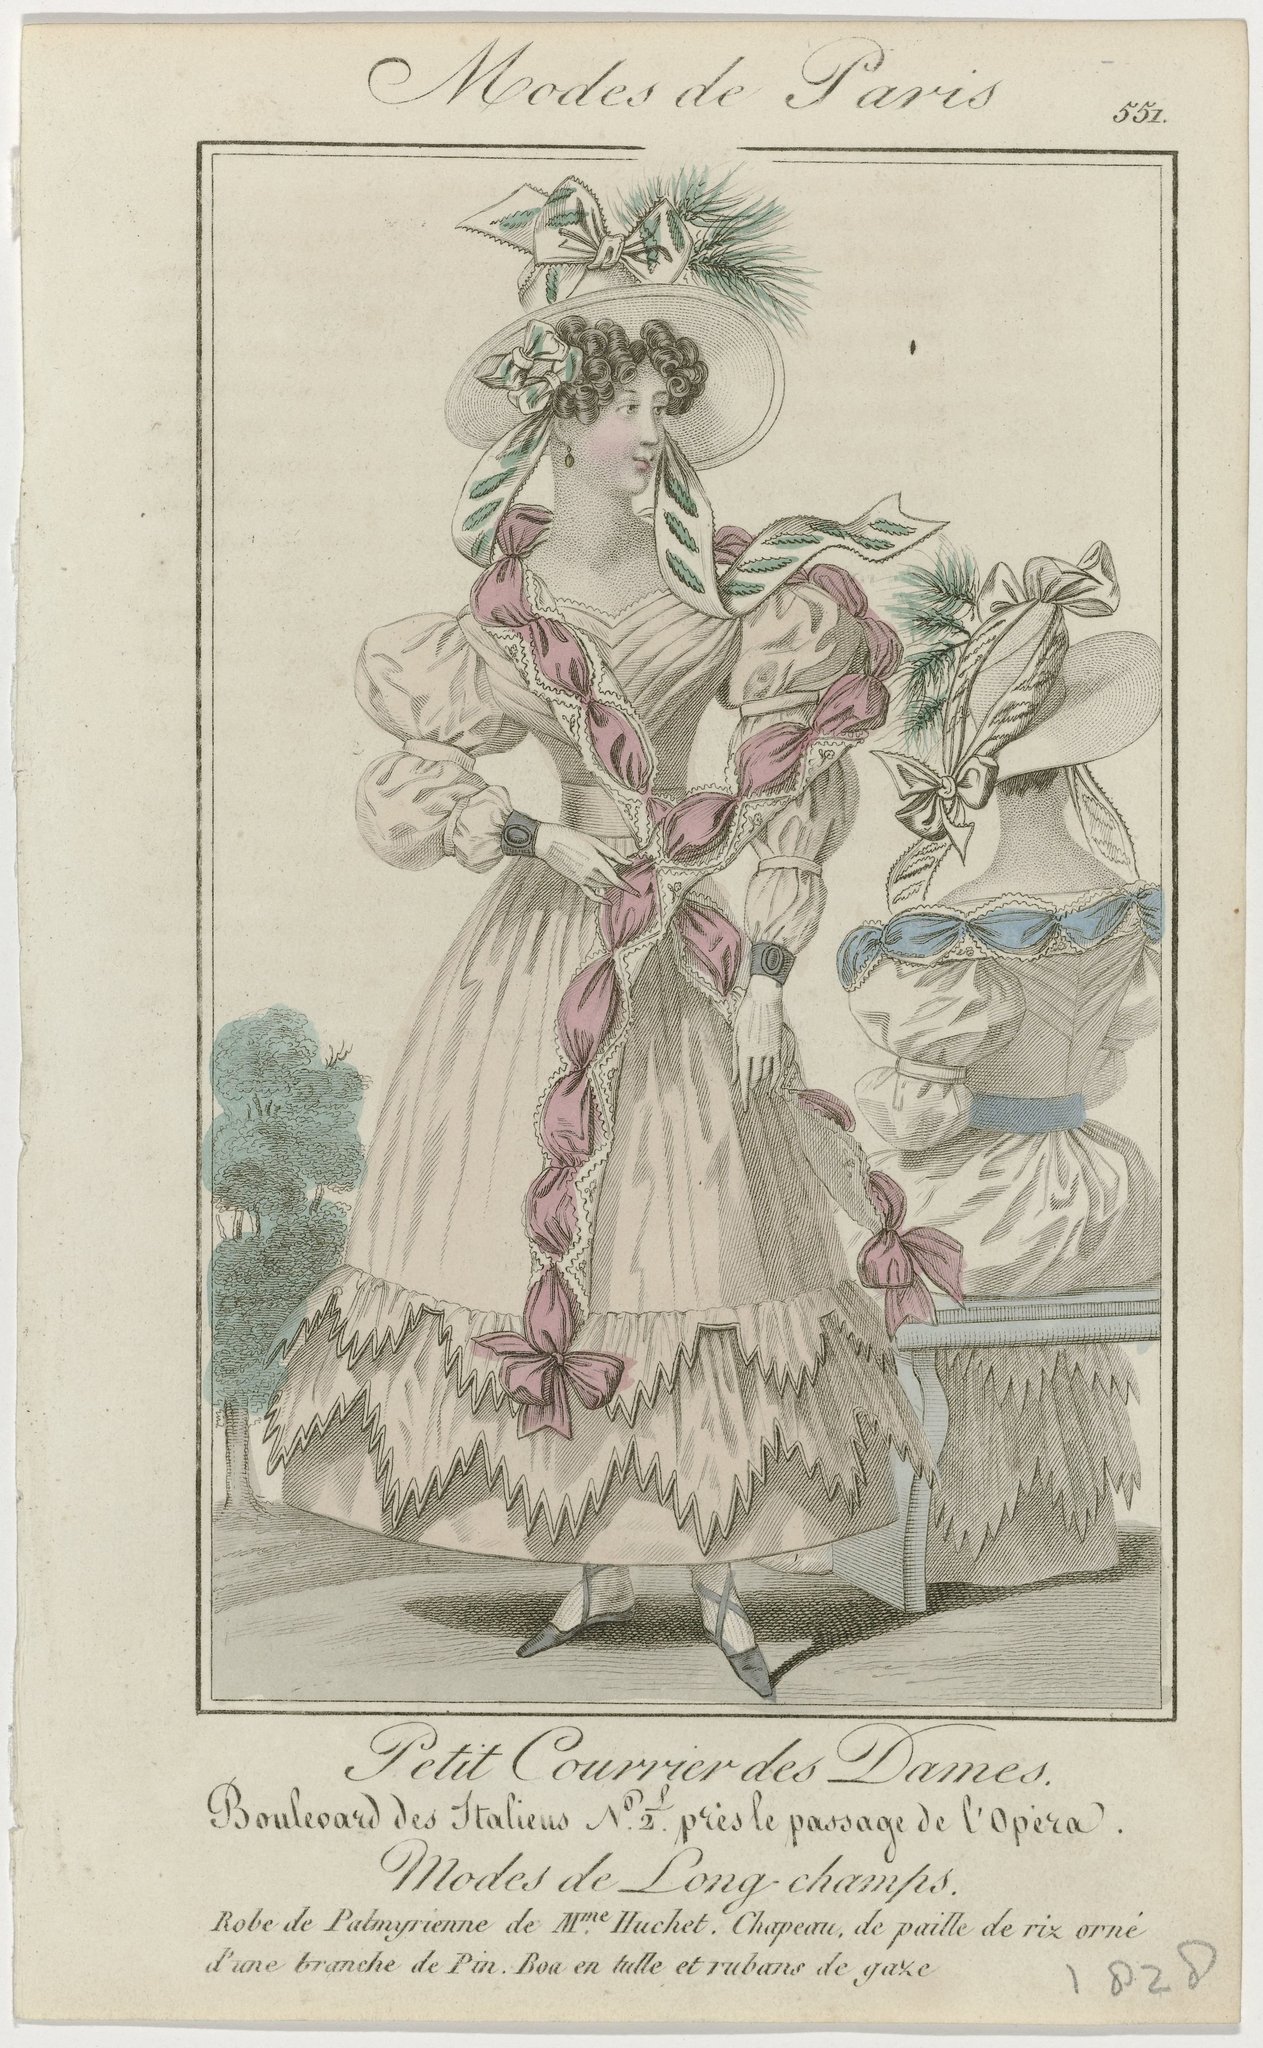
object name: fashion print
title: Petit Courrier des Dames, 1828, No. 551 : Robe de Patmyrienne..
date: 1828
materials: paper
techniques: engraving, hand coloring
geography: paris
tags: clothing for the upper part of the body (boa) (+ women's clothes), fashion plates, head-gear: hat (+ women's clothes), shoes, sandals (+ women's clothes), gloves, mittens, etc. (+ women's clothes), dress, gown (+ women's clothes), neck-gear ~ clothing (+ women's clothes), bracelet, wristlet (+ women's clothes)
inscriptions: caption: ‘Robe de Palmyrienne de M.me Huchet. Chapeau de paille de riz orné d'une branche de Pin. Boa en tulle et rubans de gaze’, address: ‘Boulevard des Italiens No.2 près le passage de l'Opèra.’, title: ‘Modes de Paris.’, title: ‘Petit Courrier des Dames. / Modes de Long-champs.’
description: Staande vrouw gekleed in een japon van 'palmyrienne' van Huchet. Op het hoofd een hoed van 'paille de riz', versierd met een dennentak. Boa van tule en linten van gaas. Zittende figuur in eenzelfde japon, op de rug gezien. Prent uit het modetijdschrift Petit Courrier des Dames (1821-1868).